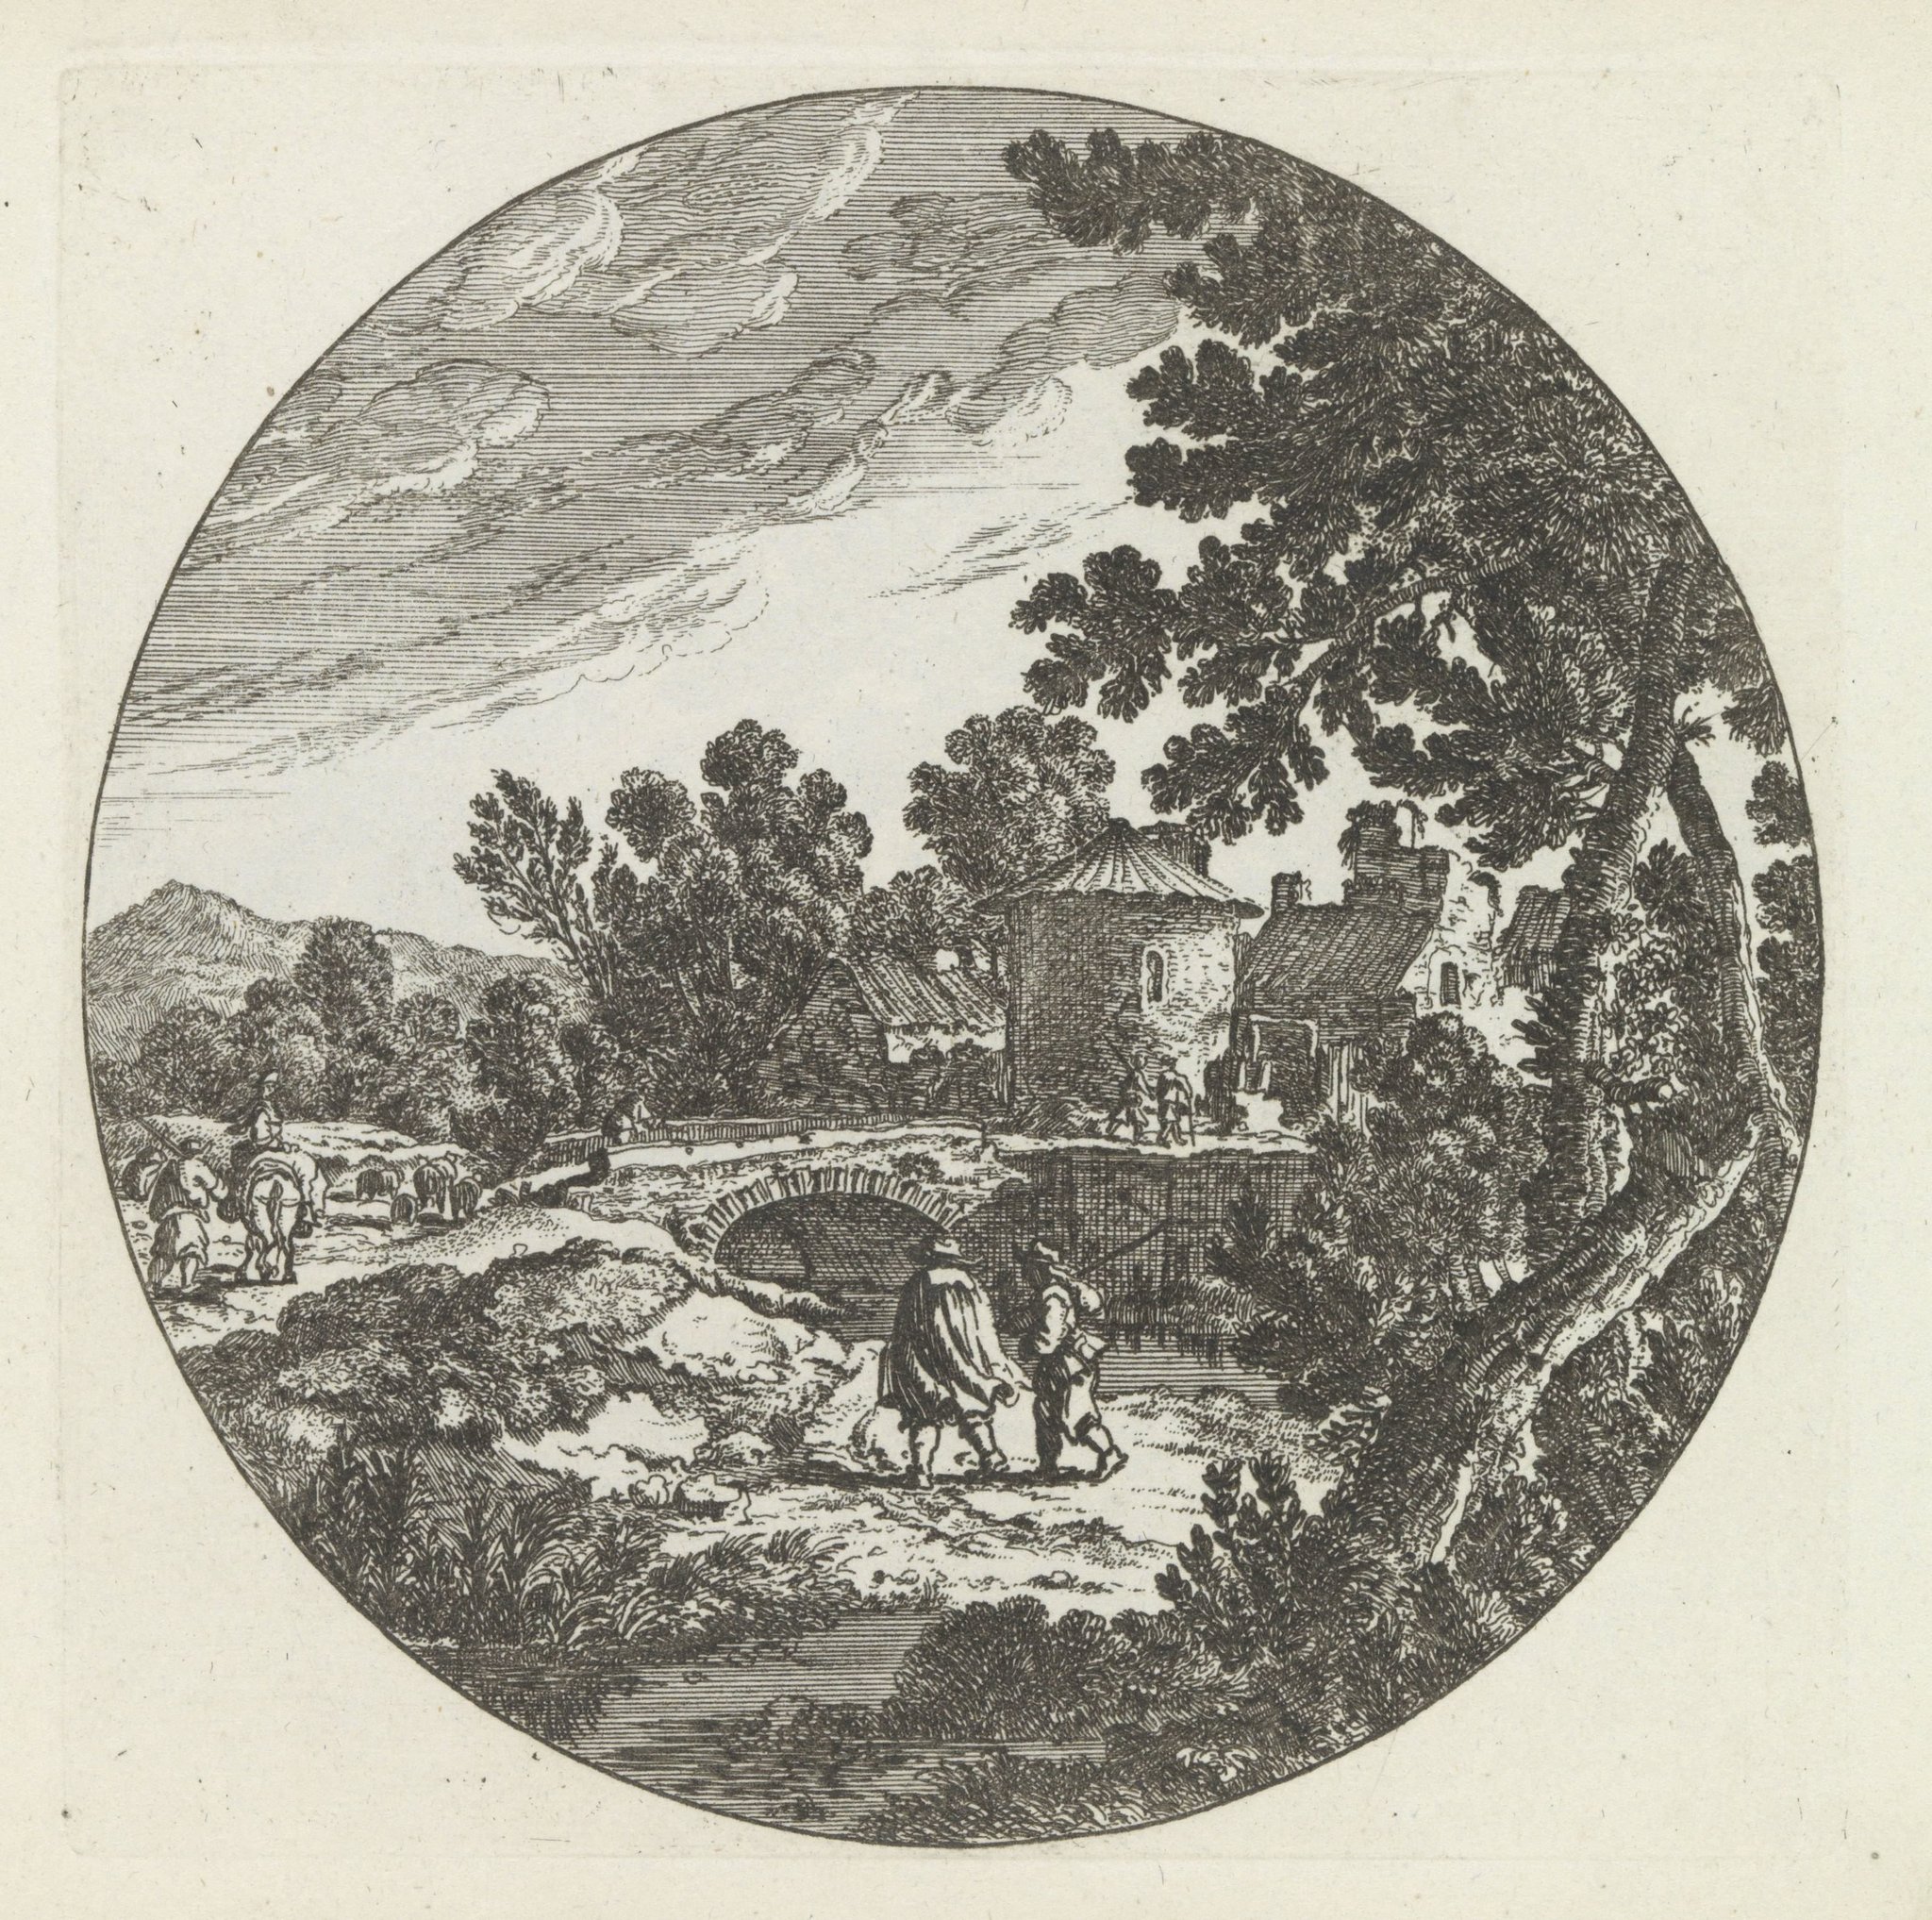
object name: print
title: Landschappen met rond kader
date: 1614-1656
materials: paper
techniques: etching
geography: amsterdam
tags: landscapes, forest, wood, landscape with bridge, viaduct or aqueduct - ii - ideal landscapes